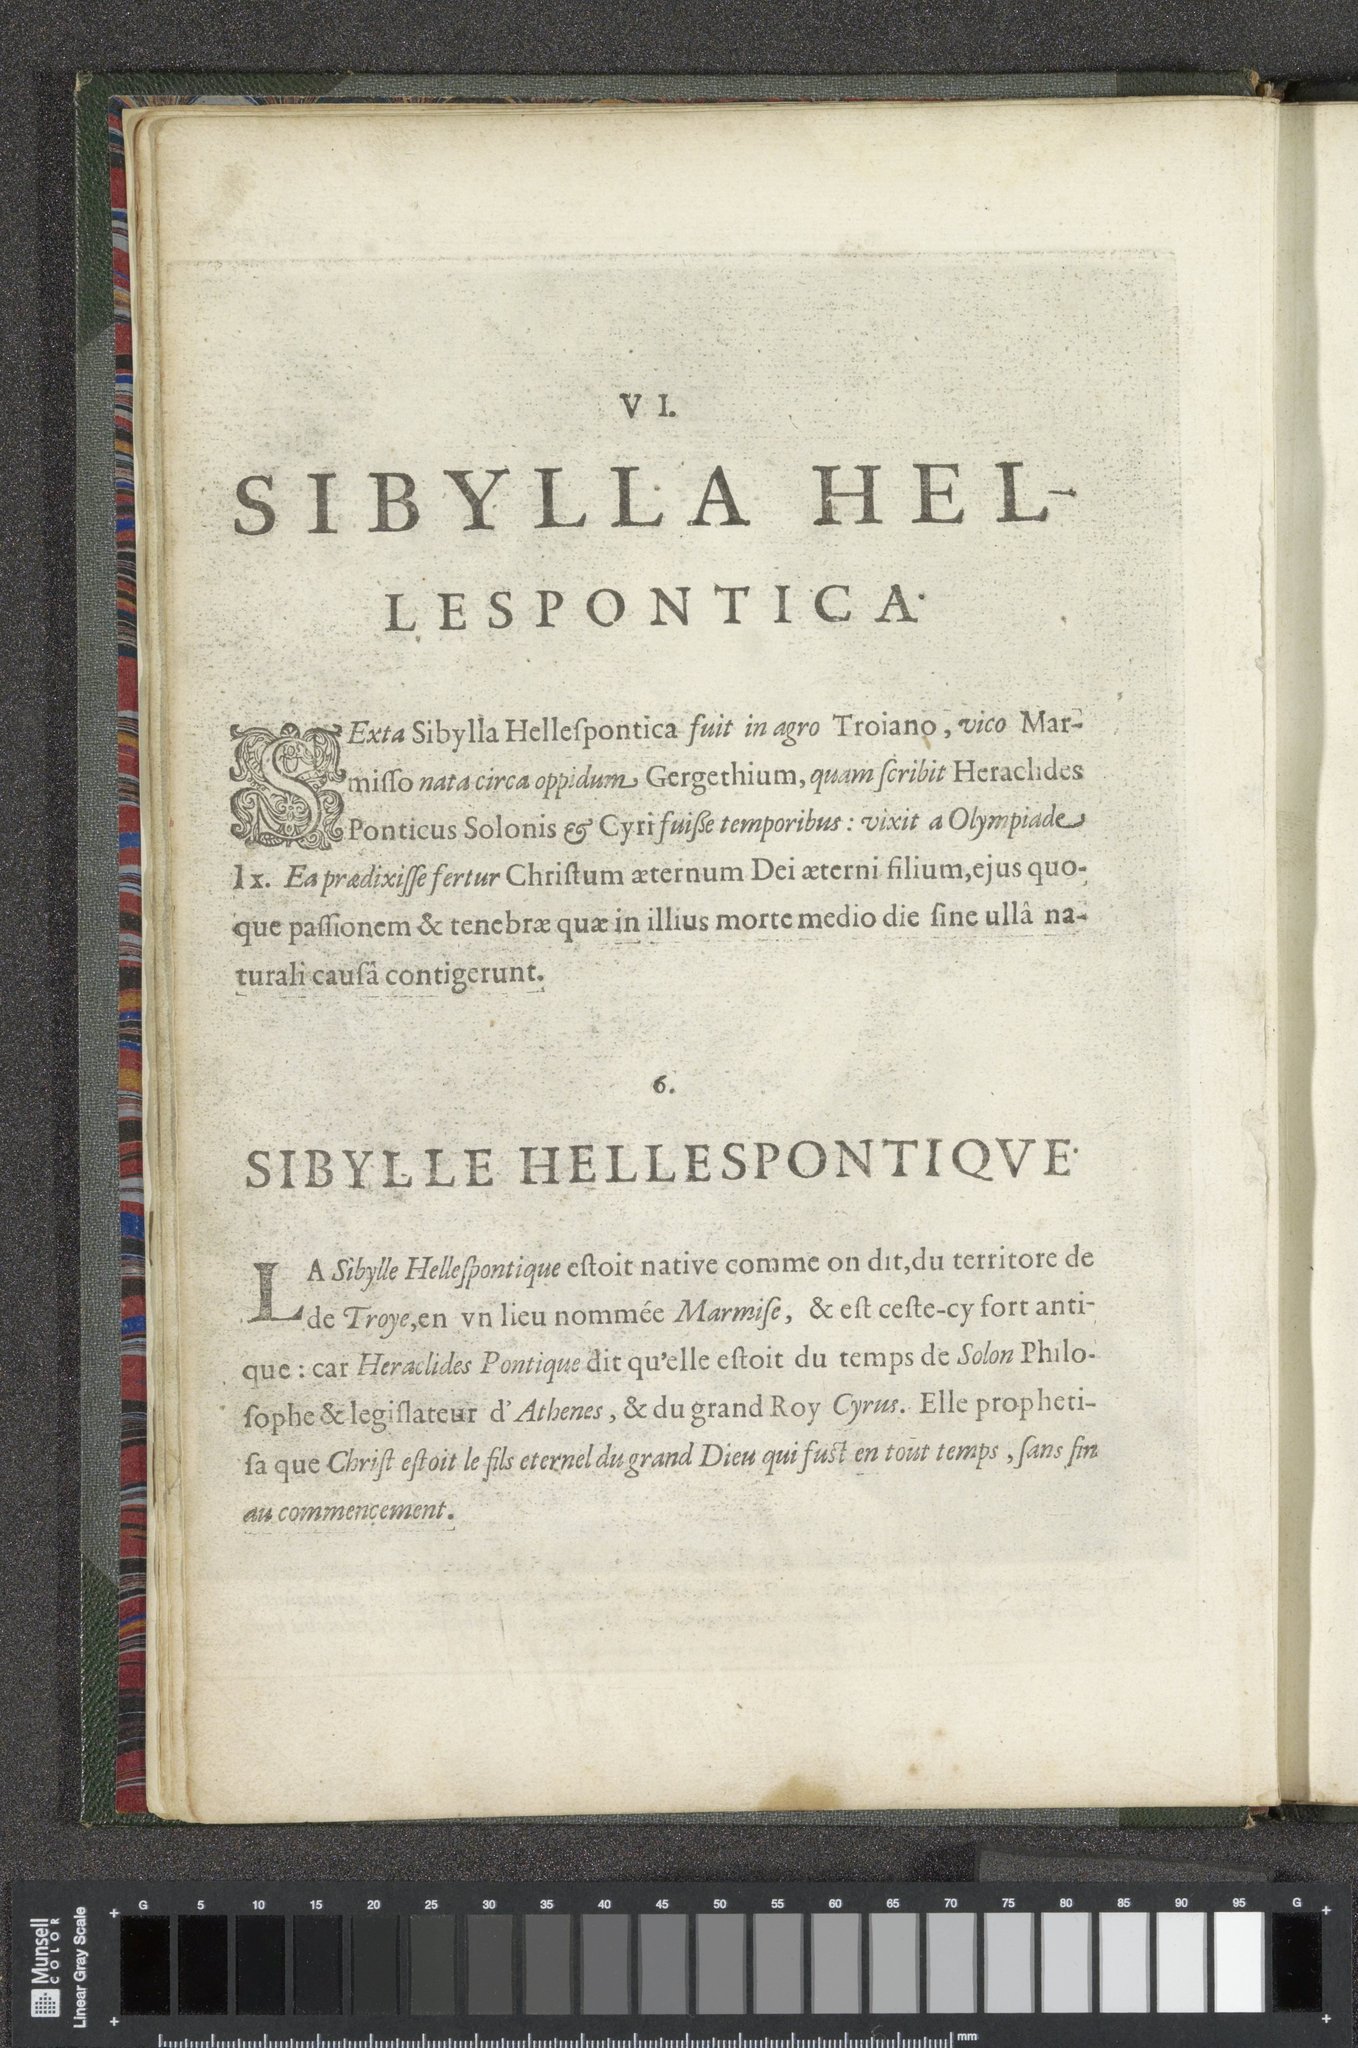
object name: album leaf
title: Sibylla Hellespontica / Sibylle Hellespontique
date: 1615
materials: paper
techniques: letterpress printing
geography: utrecht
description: Een tekst in het Latijn en het Frans over een prent met een voorstelling van de Hellespontische Sibille. Dit blad maakt deel uit van een album.